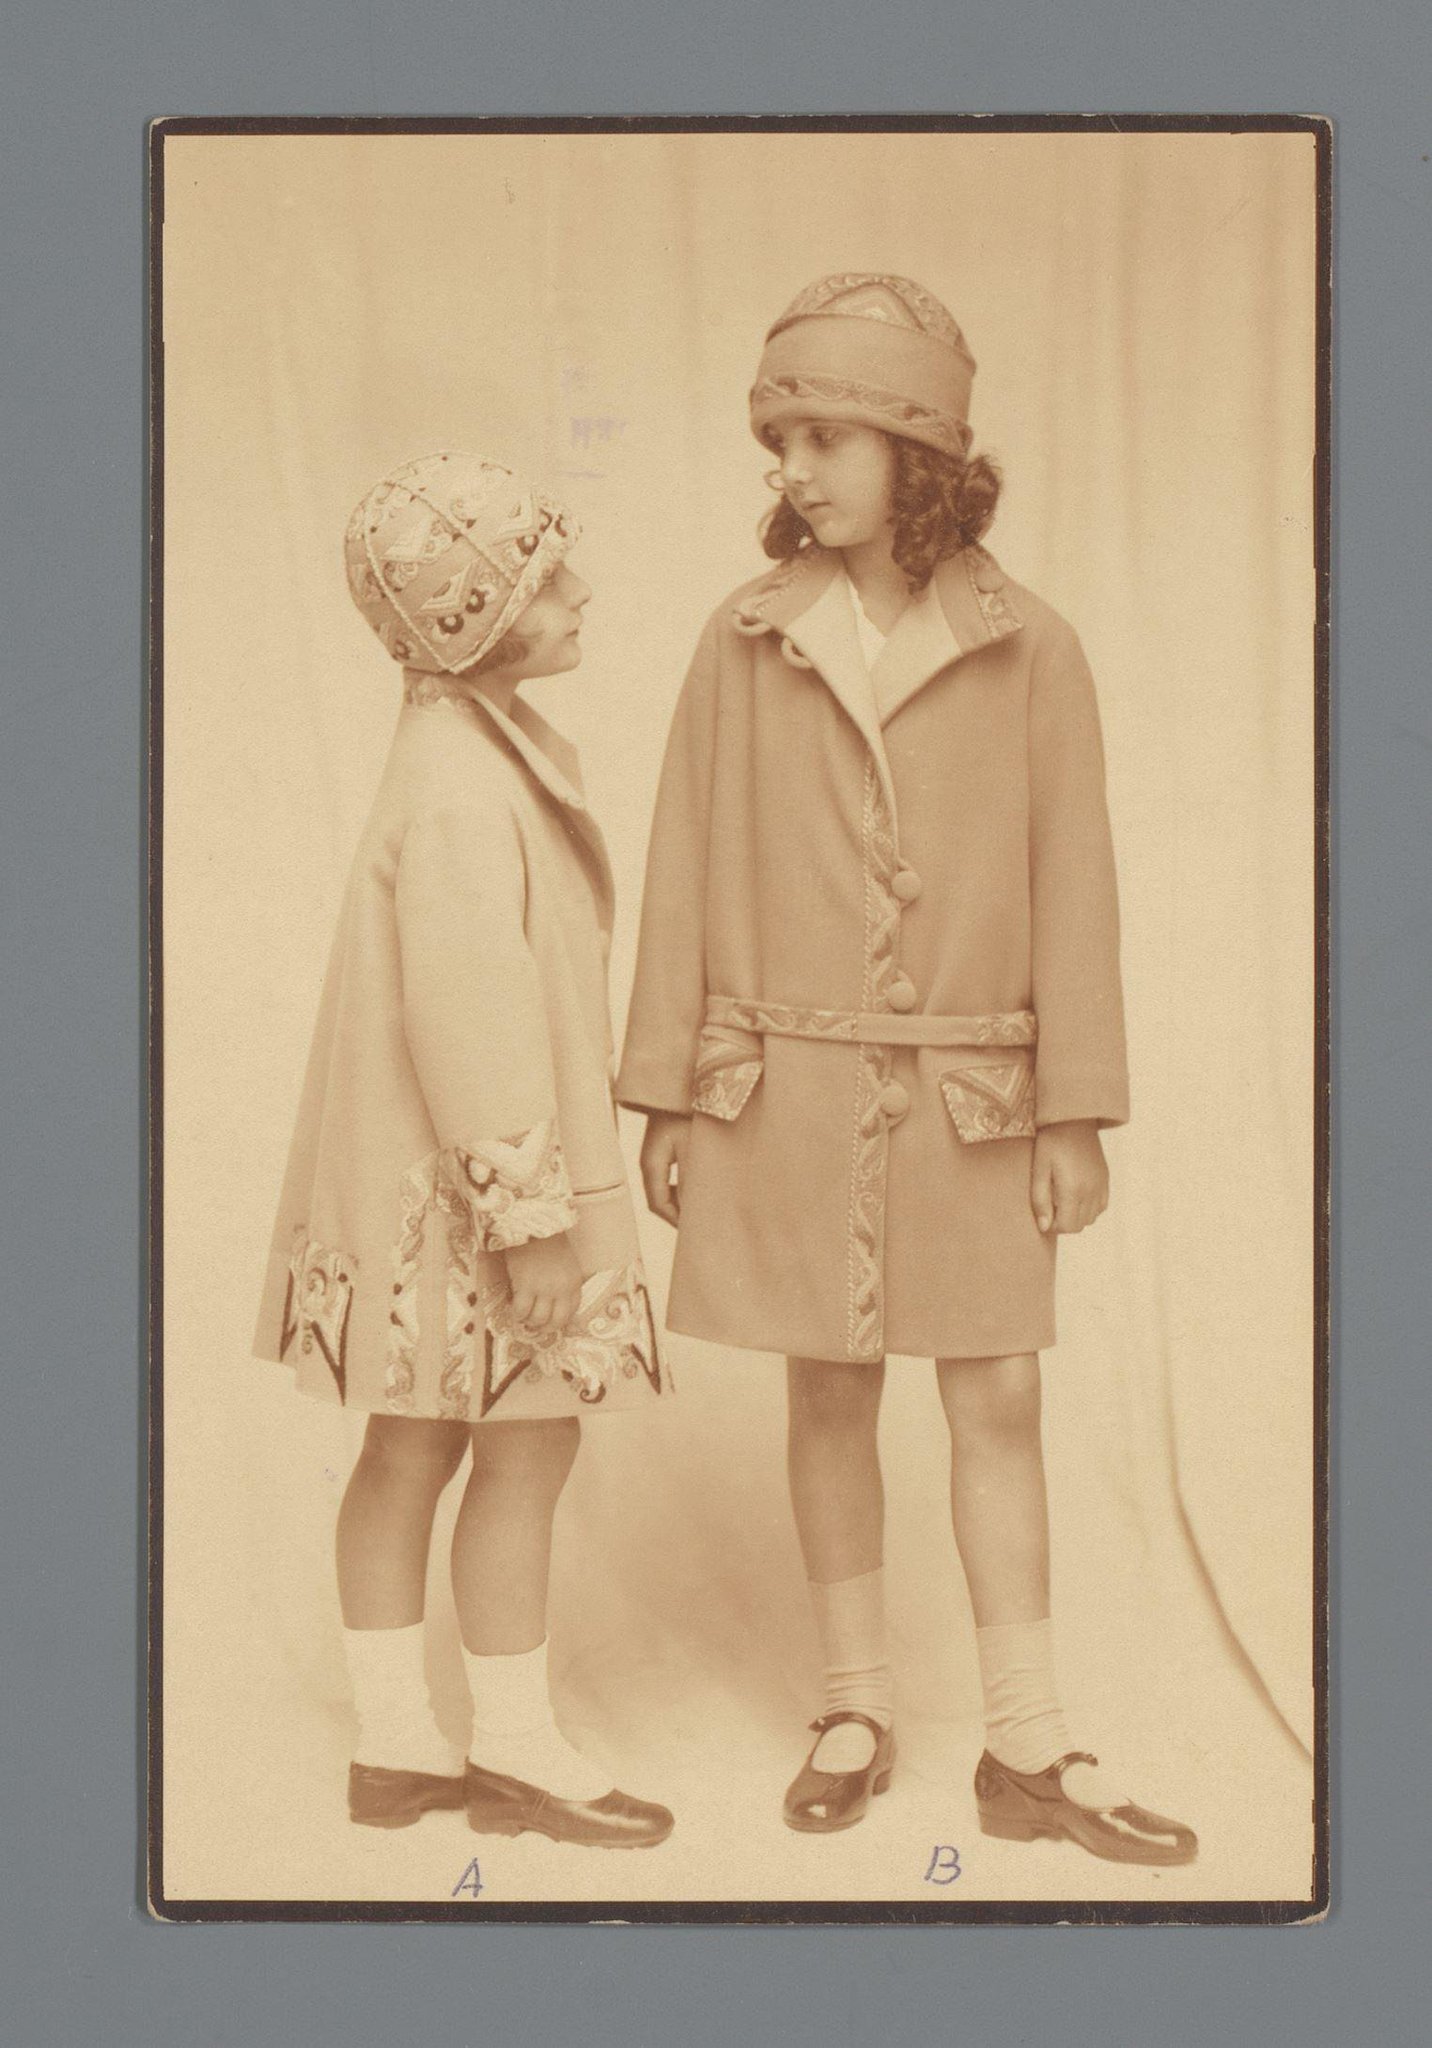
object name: photograph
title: Twee modellen met geborduurde jassen en mutsen van de Wiener Werkstätte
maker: Anonymous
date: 1920-1930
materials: photographic support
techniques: gelatin silver print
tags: fashion plates, head-gear: cap, coat, cape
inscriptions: inscription, number: ‘87’